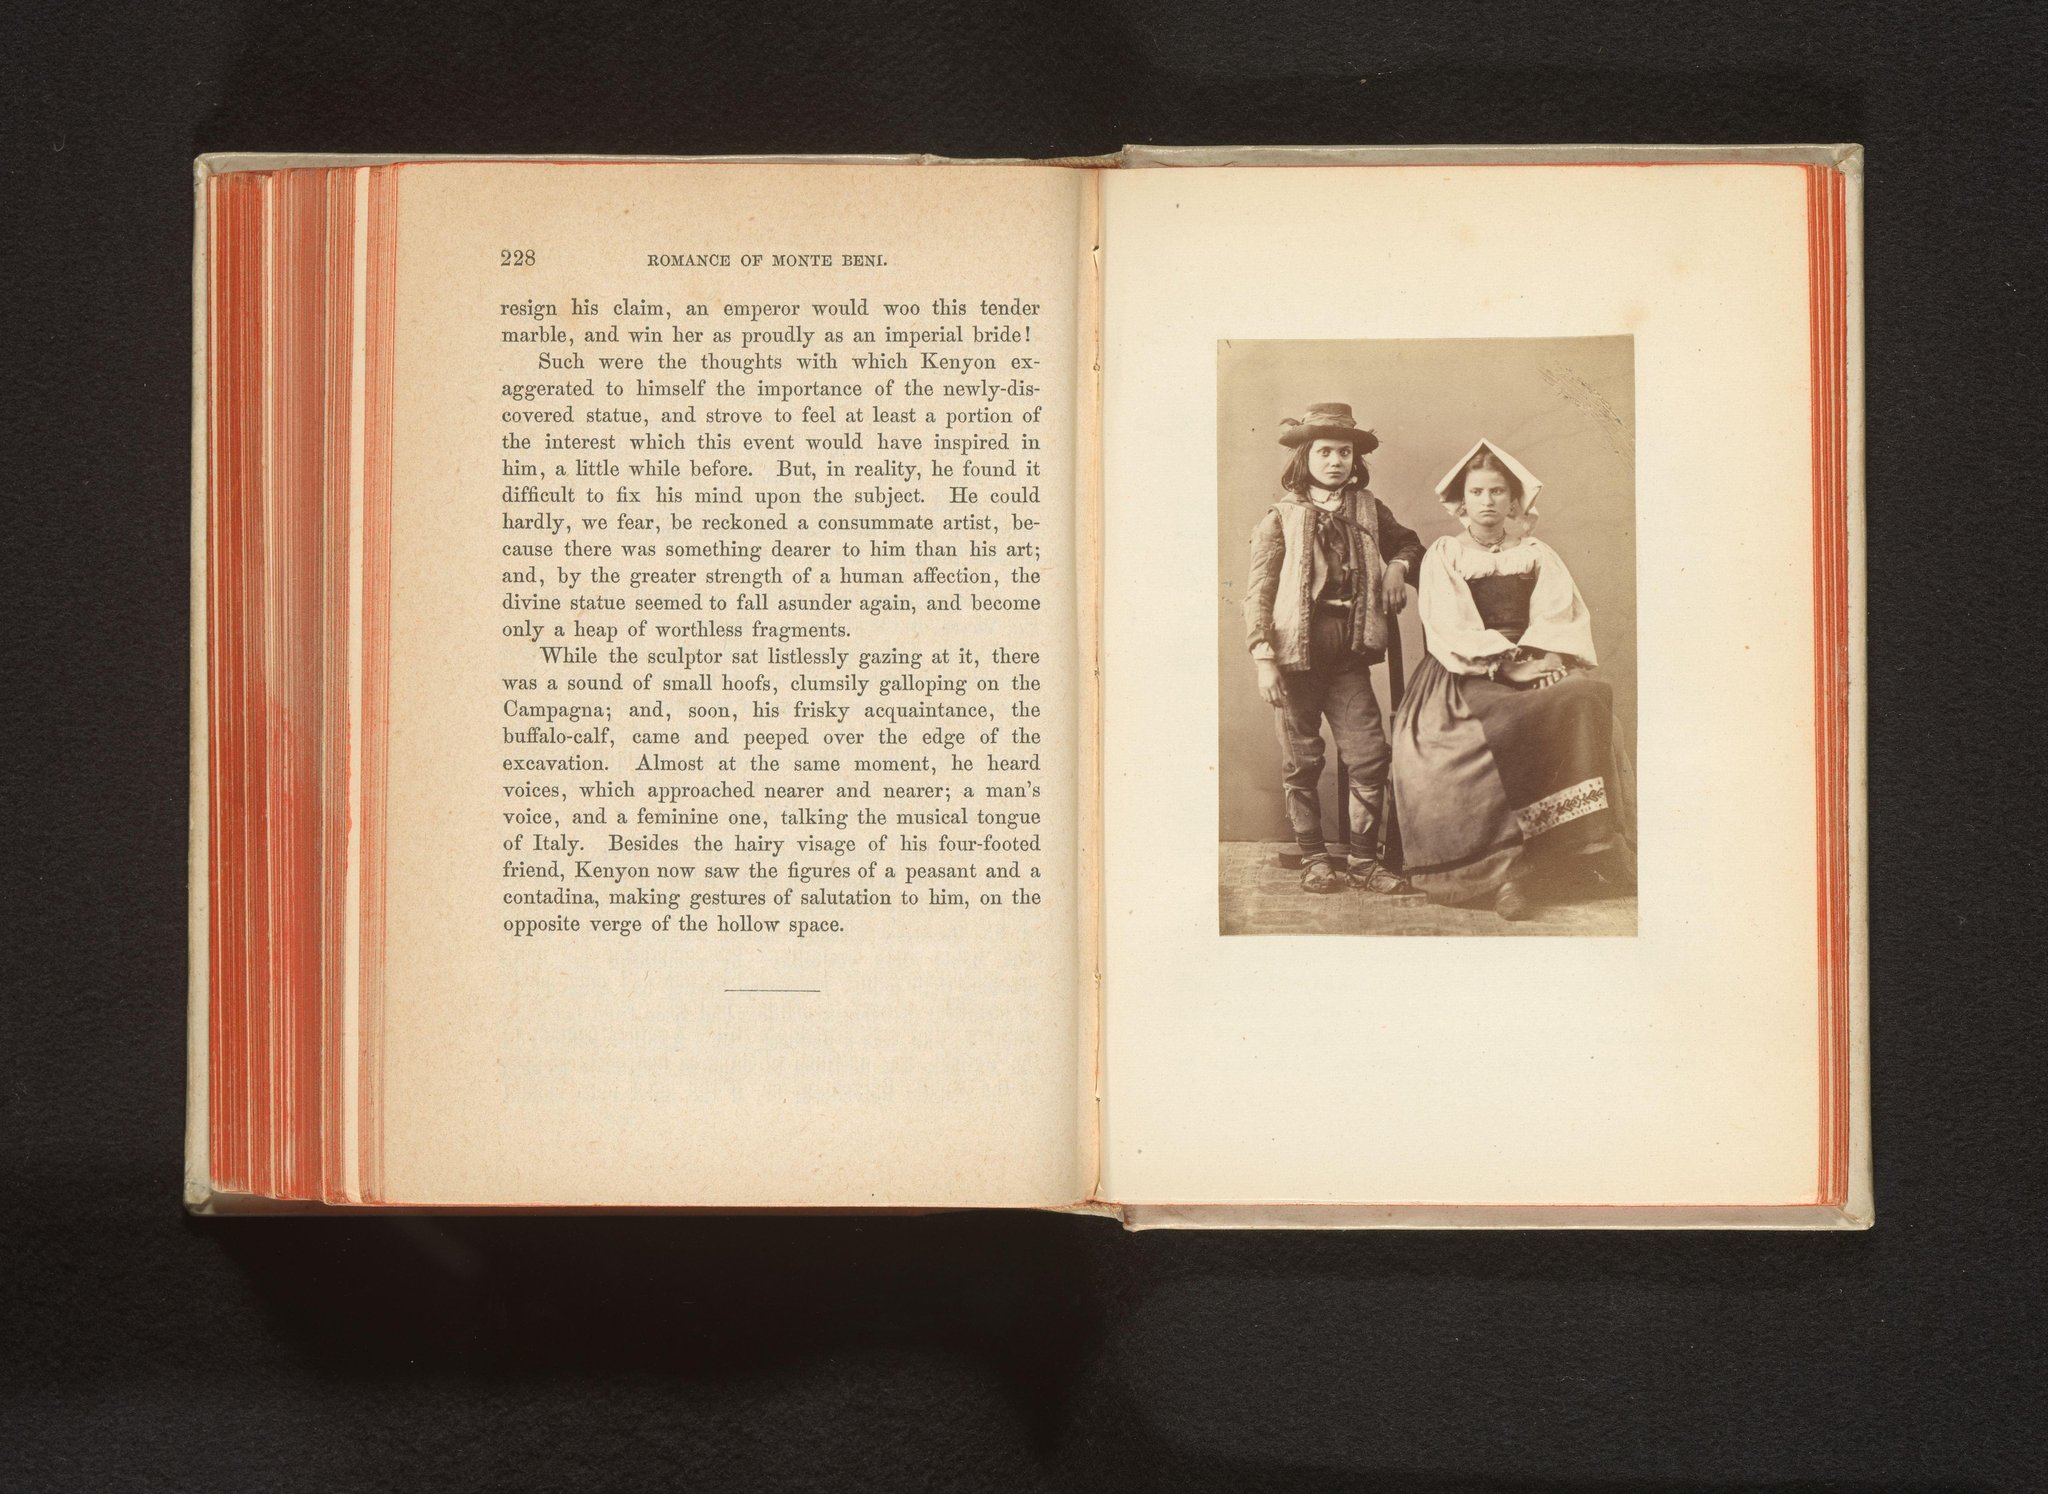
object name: photograph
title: Portret van twee onbekende mensen in traditionele Italiaanse kleding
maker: Anonymous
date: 1850-1860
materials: photographic support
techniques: albumen print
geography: italy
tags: folk costume, regional costume